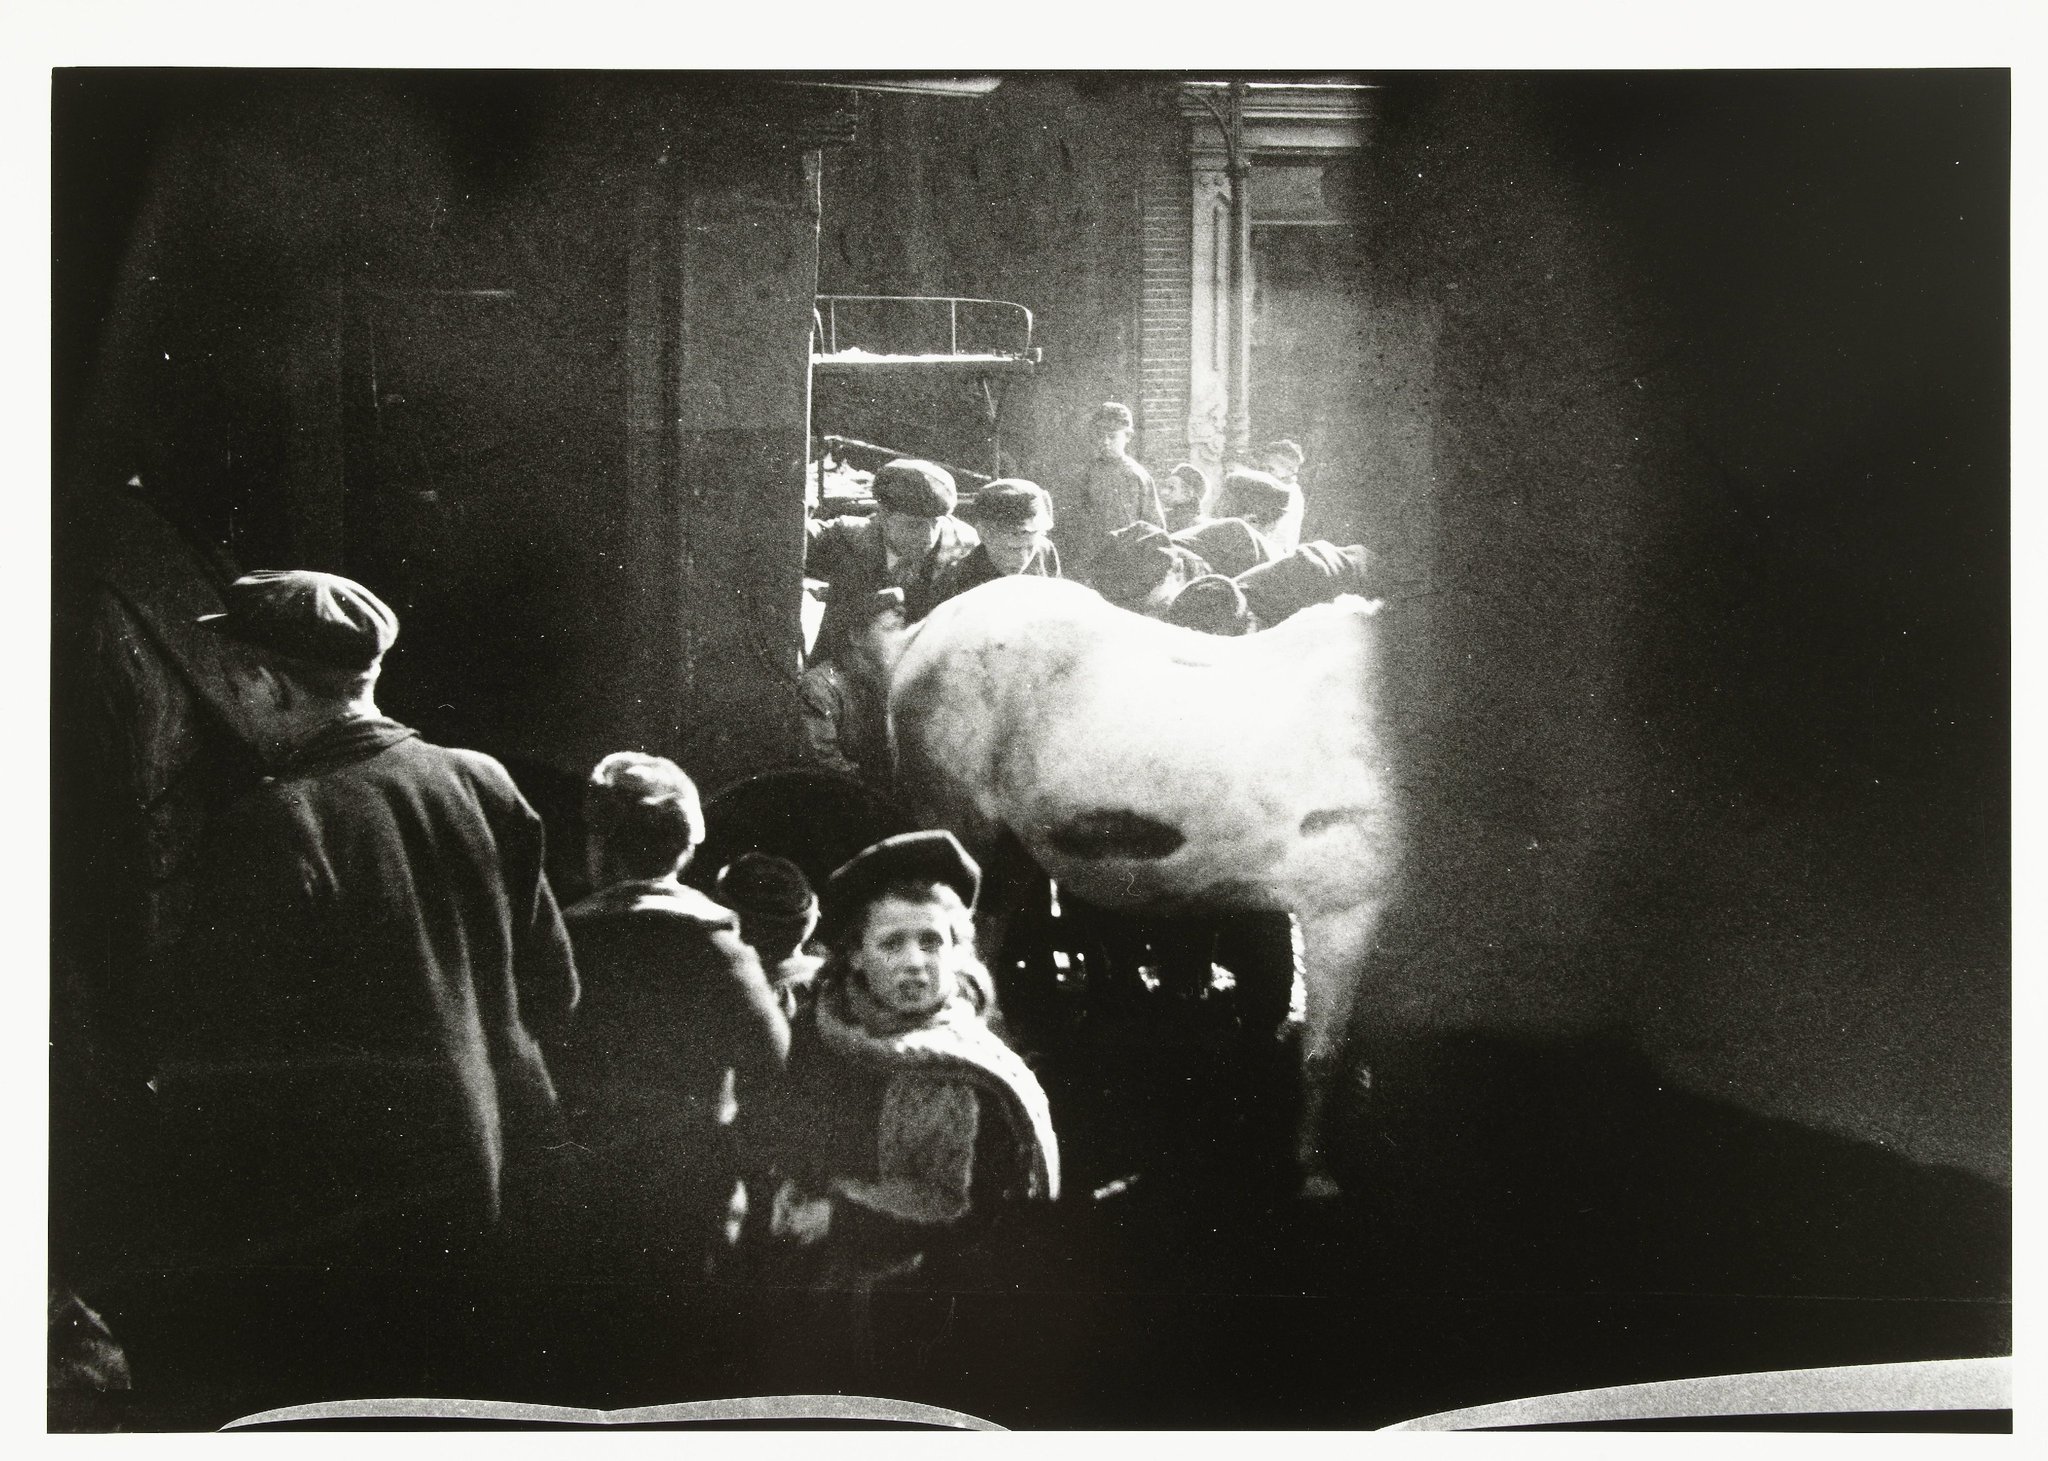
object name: photograph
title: Bezoekers op een paardenmarkt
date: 1890-1910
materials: paper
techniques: gelatin silver print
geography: amsterdam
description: Moderne afdruk van negatief BR 1625 (collectie RKD).